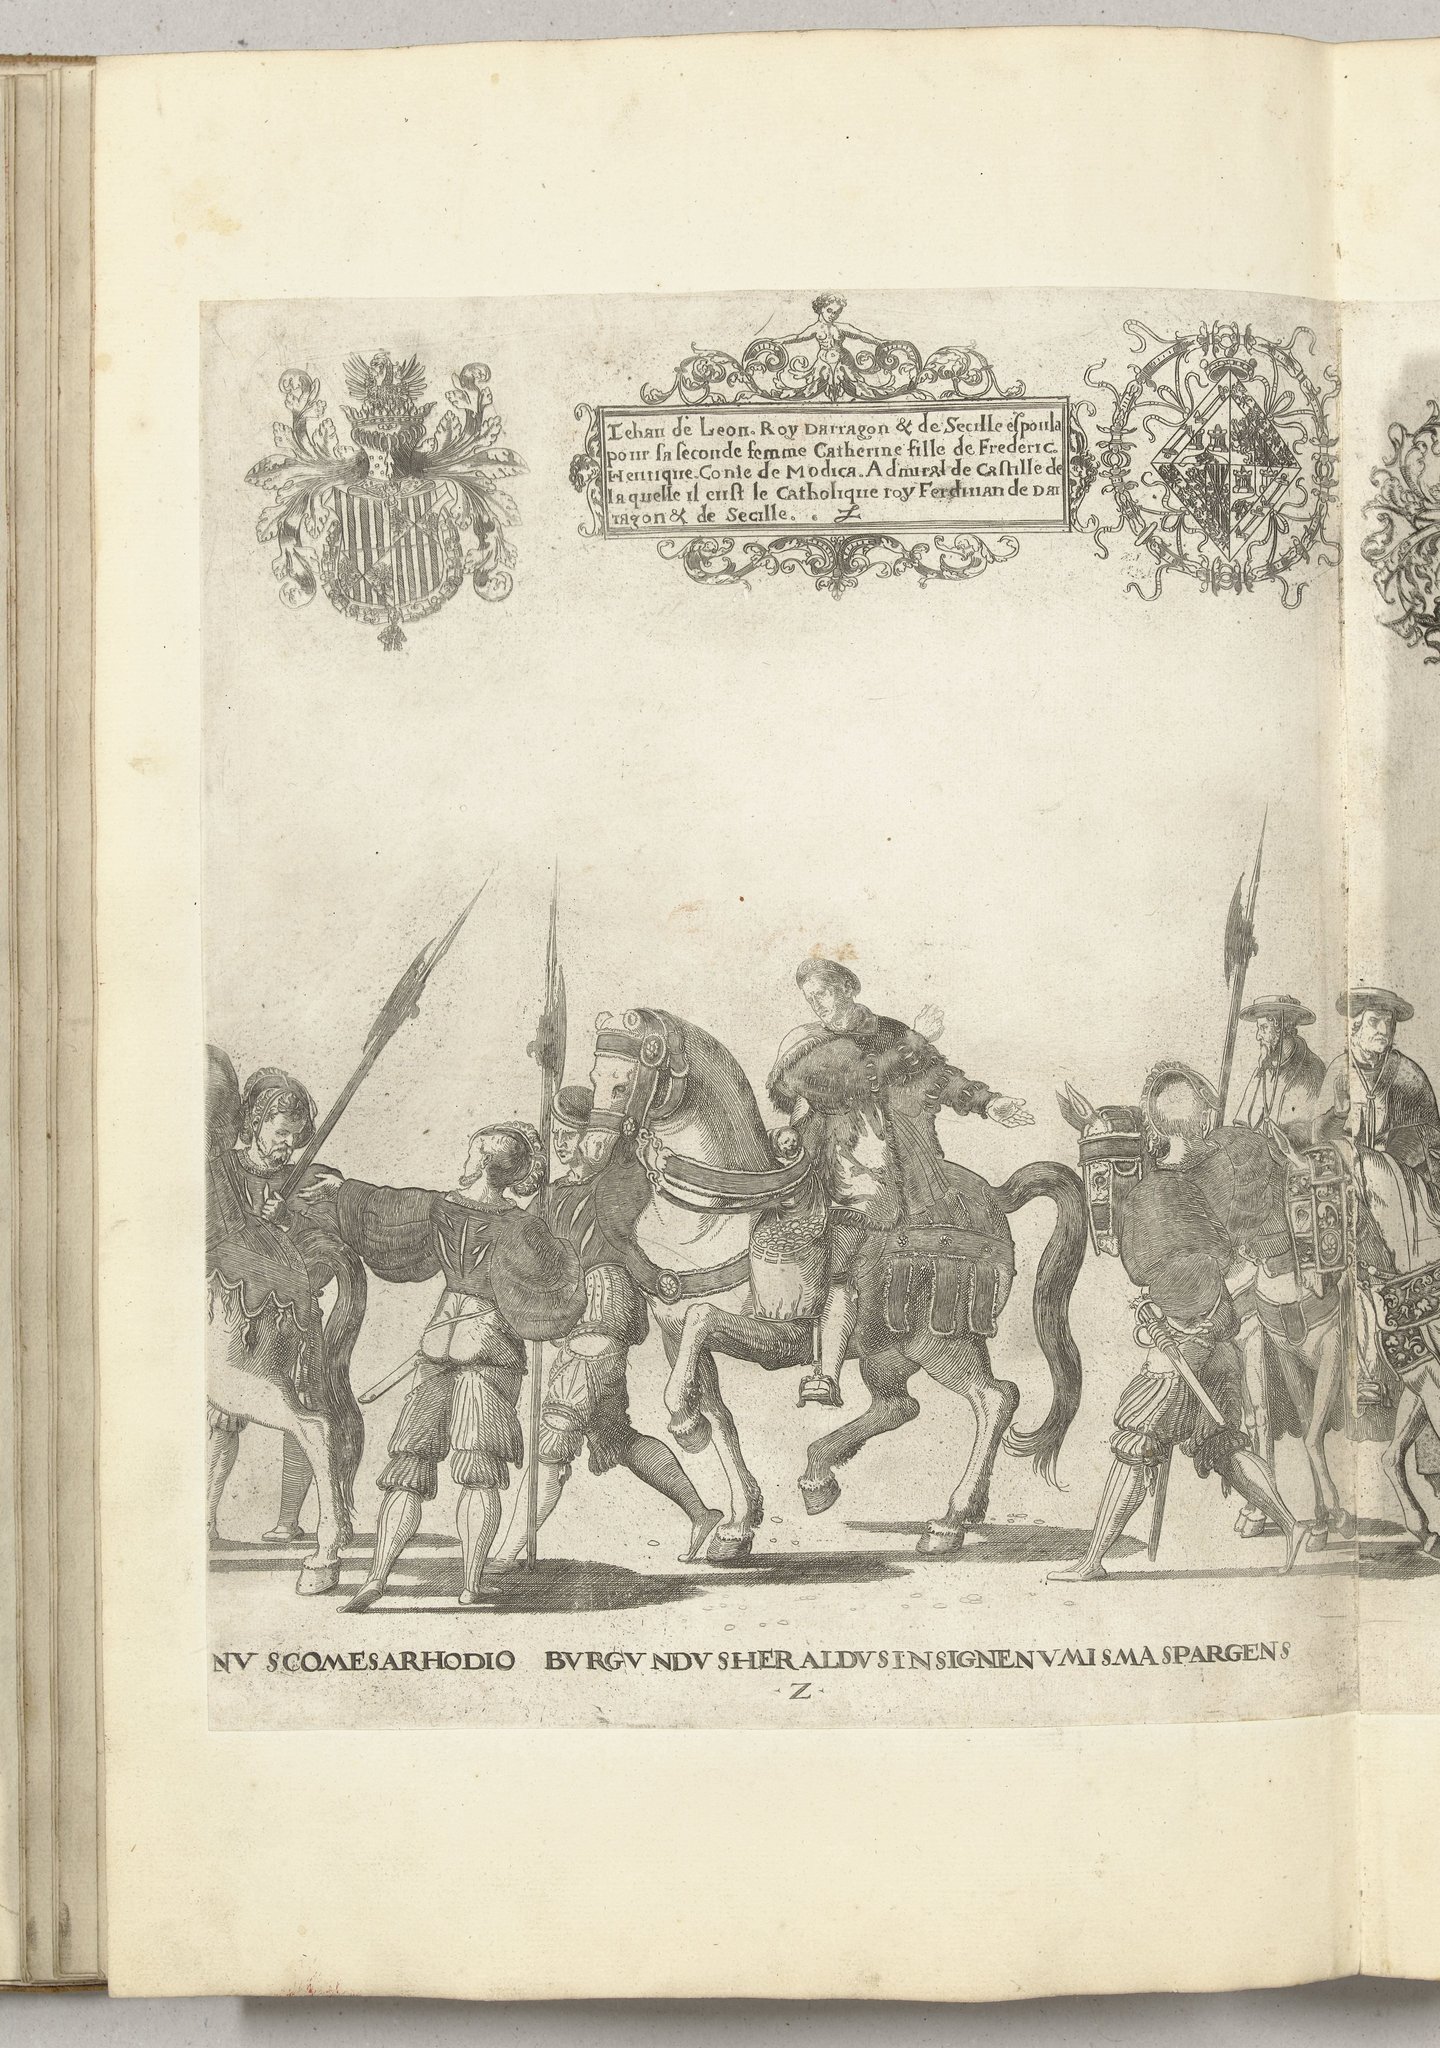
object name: print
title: Strooien van nieuwe zilveren munten met de beeltenis van keizer Karel V, plaat Z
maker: nicolaas hogenberg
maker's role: draughtsman, painter, print maker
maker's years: 1500-1539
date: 1530-1536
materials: paper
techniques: etching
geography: mechelen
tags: ghent, charles v (holy roman emperor and king of spain), rome, festivities (+ parade, pageant, cavalcade ~ festive activities)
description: Prent in het album waarin zijn ingeplakt de 40 platen die achterelkaar samen het fries vormen van de optocht van Karel V met de paus Clemens VII te Bologna na zijn kroning tot keizer, 24 februari 1530.